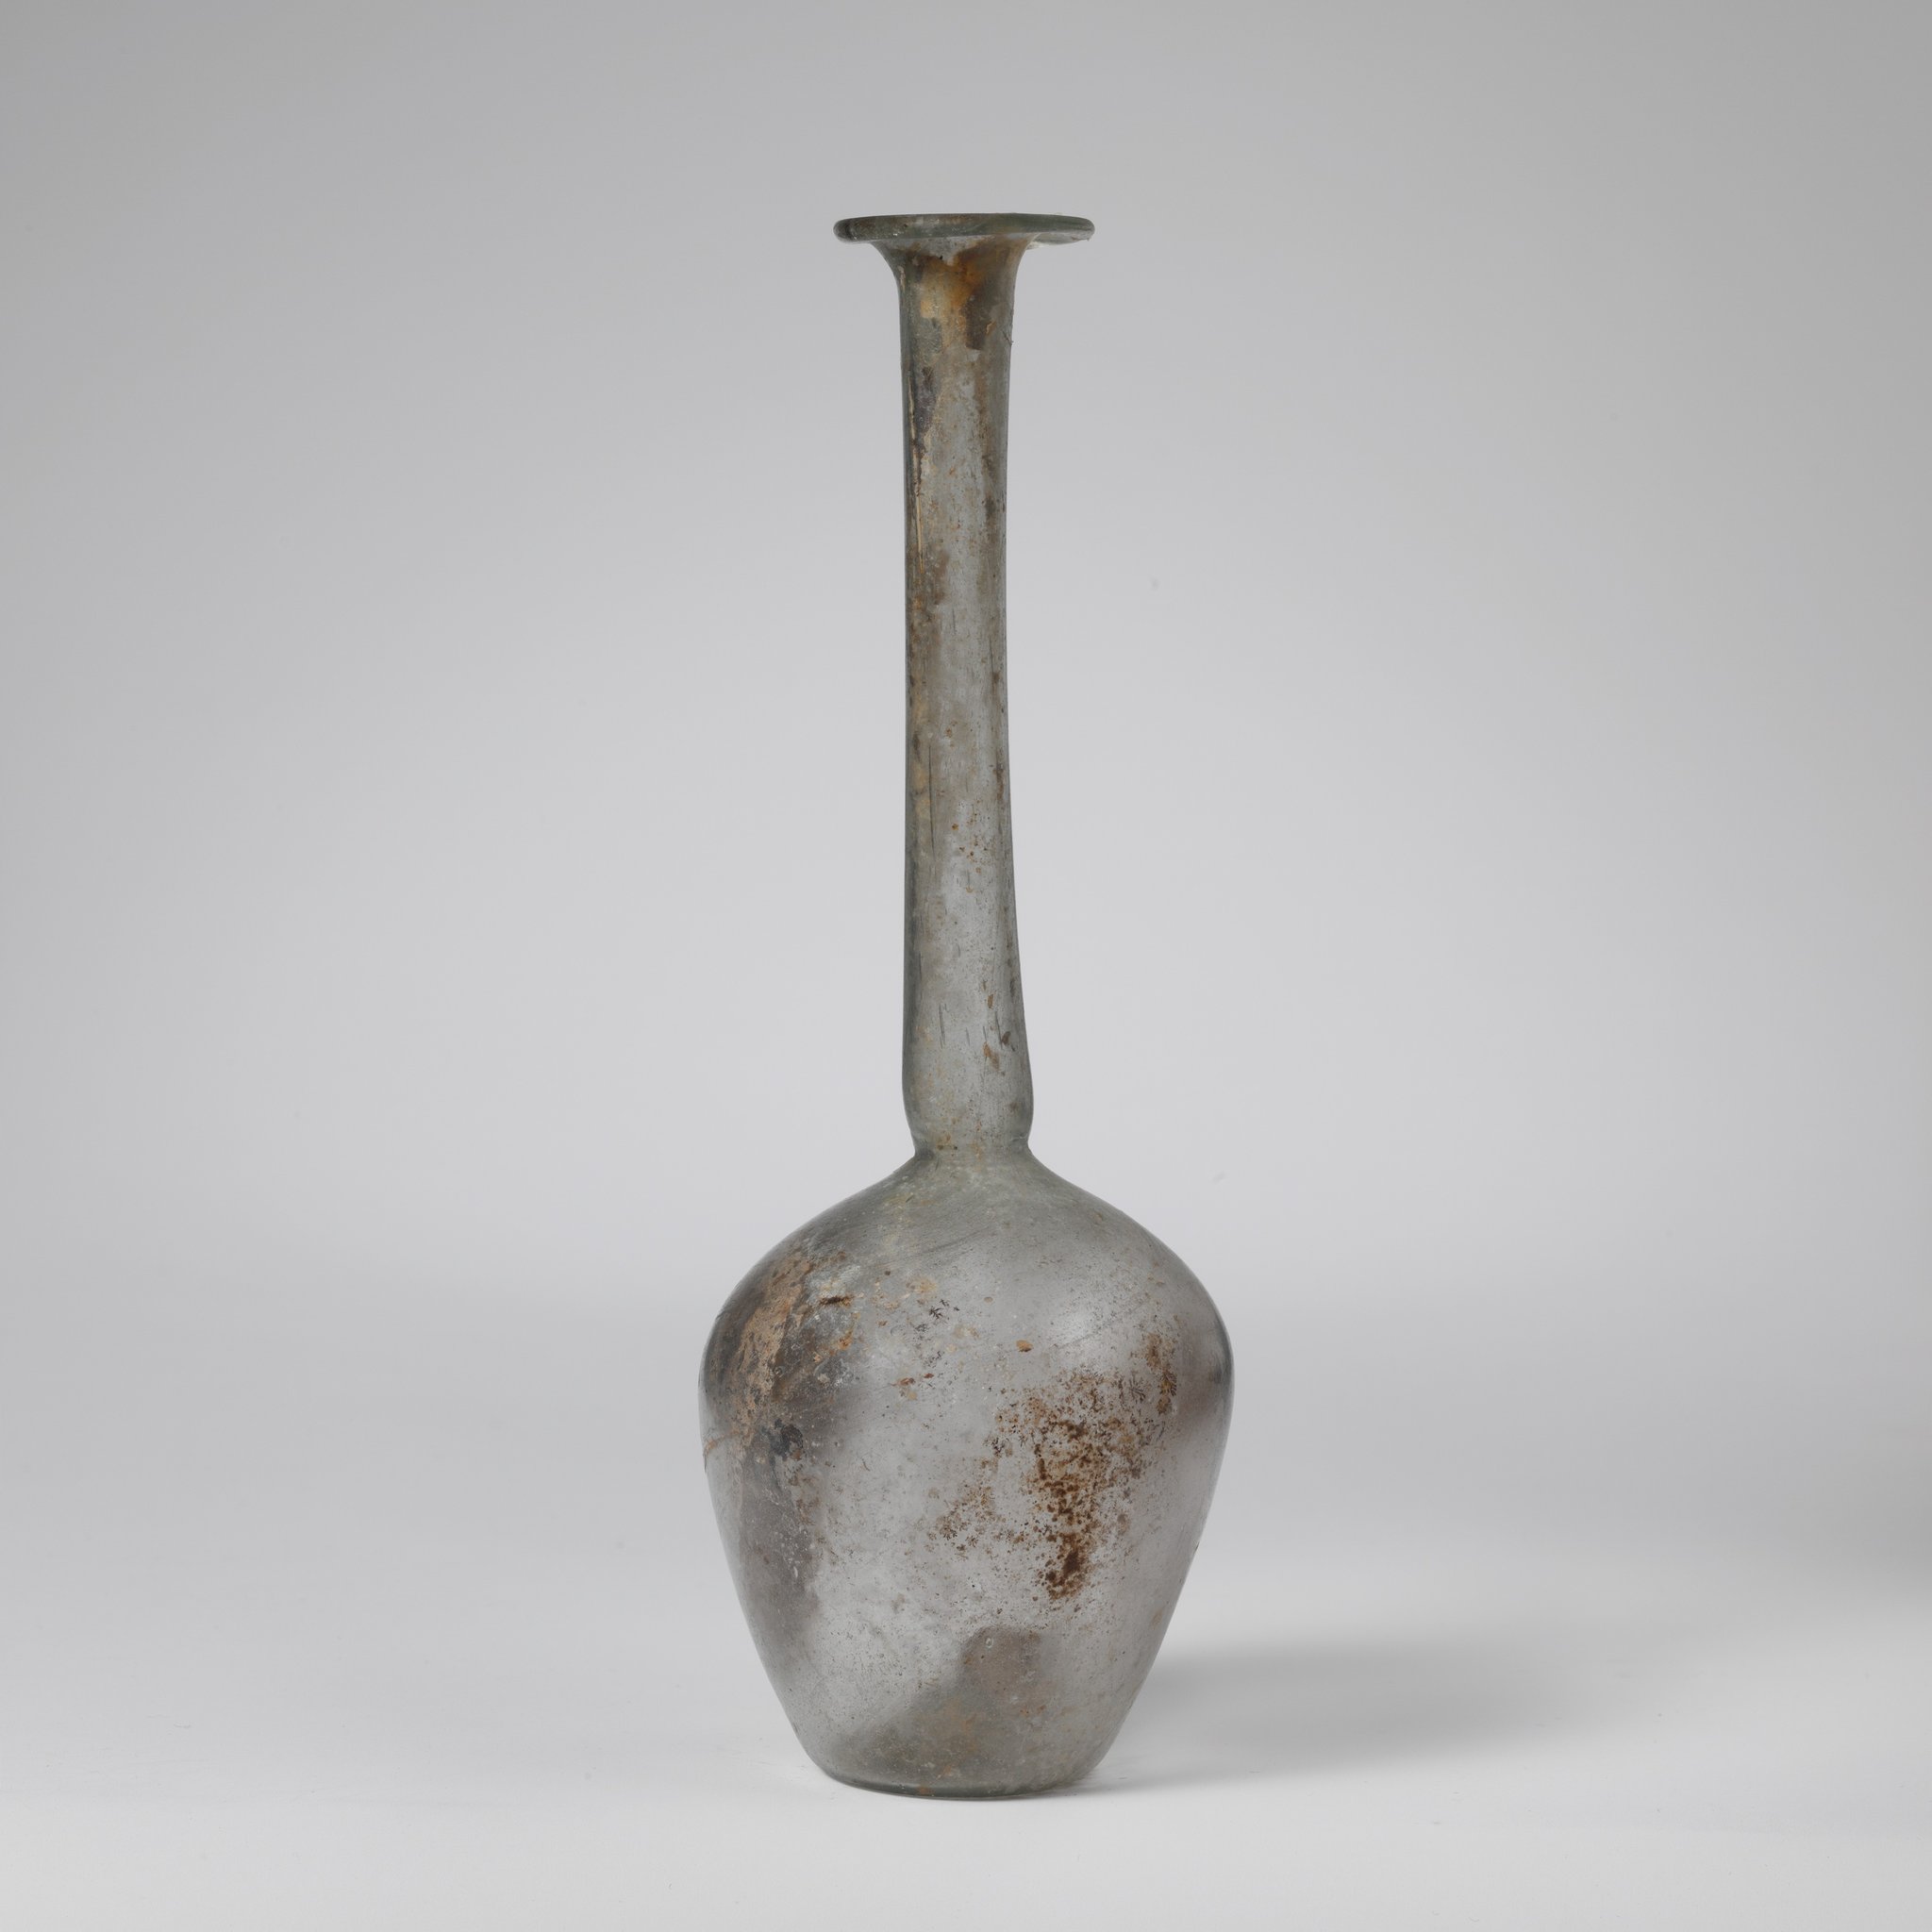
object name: perfume bottle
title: Glass perfume bottle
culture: roman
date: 101-300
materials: glass